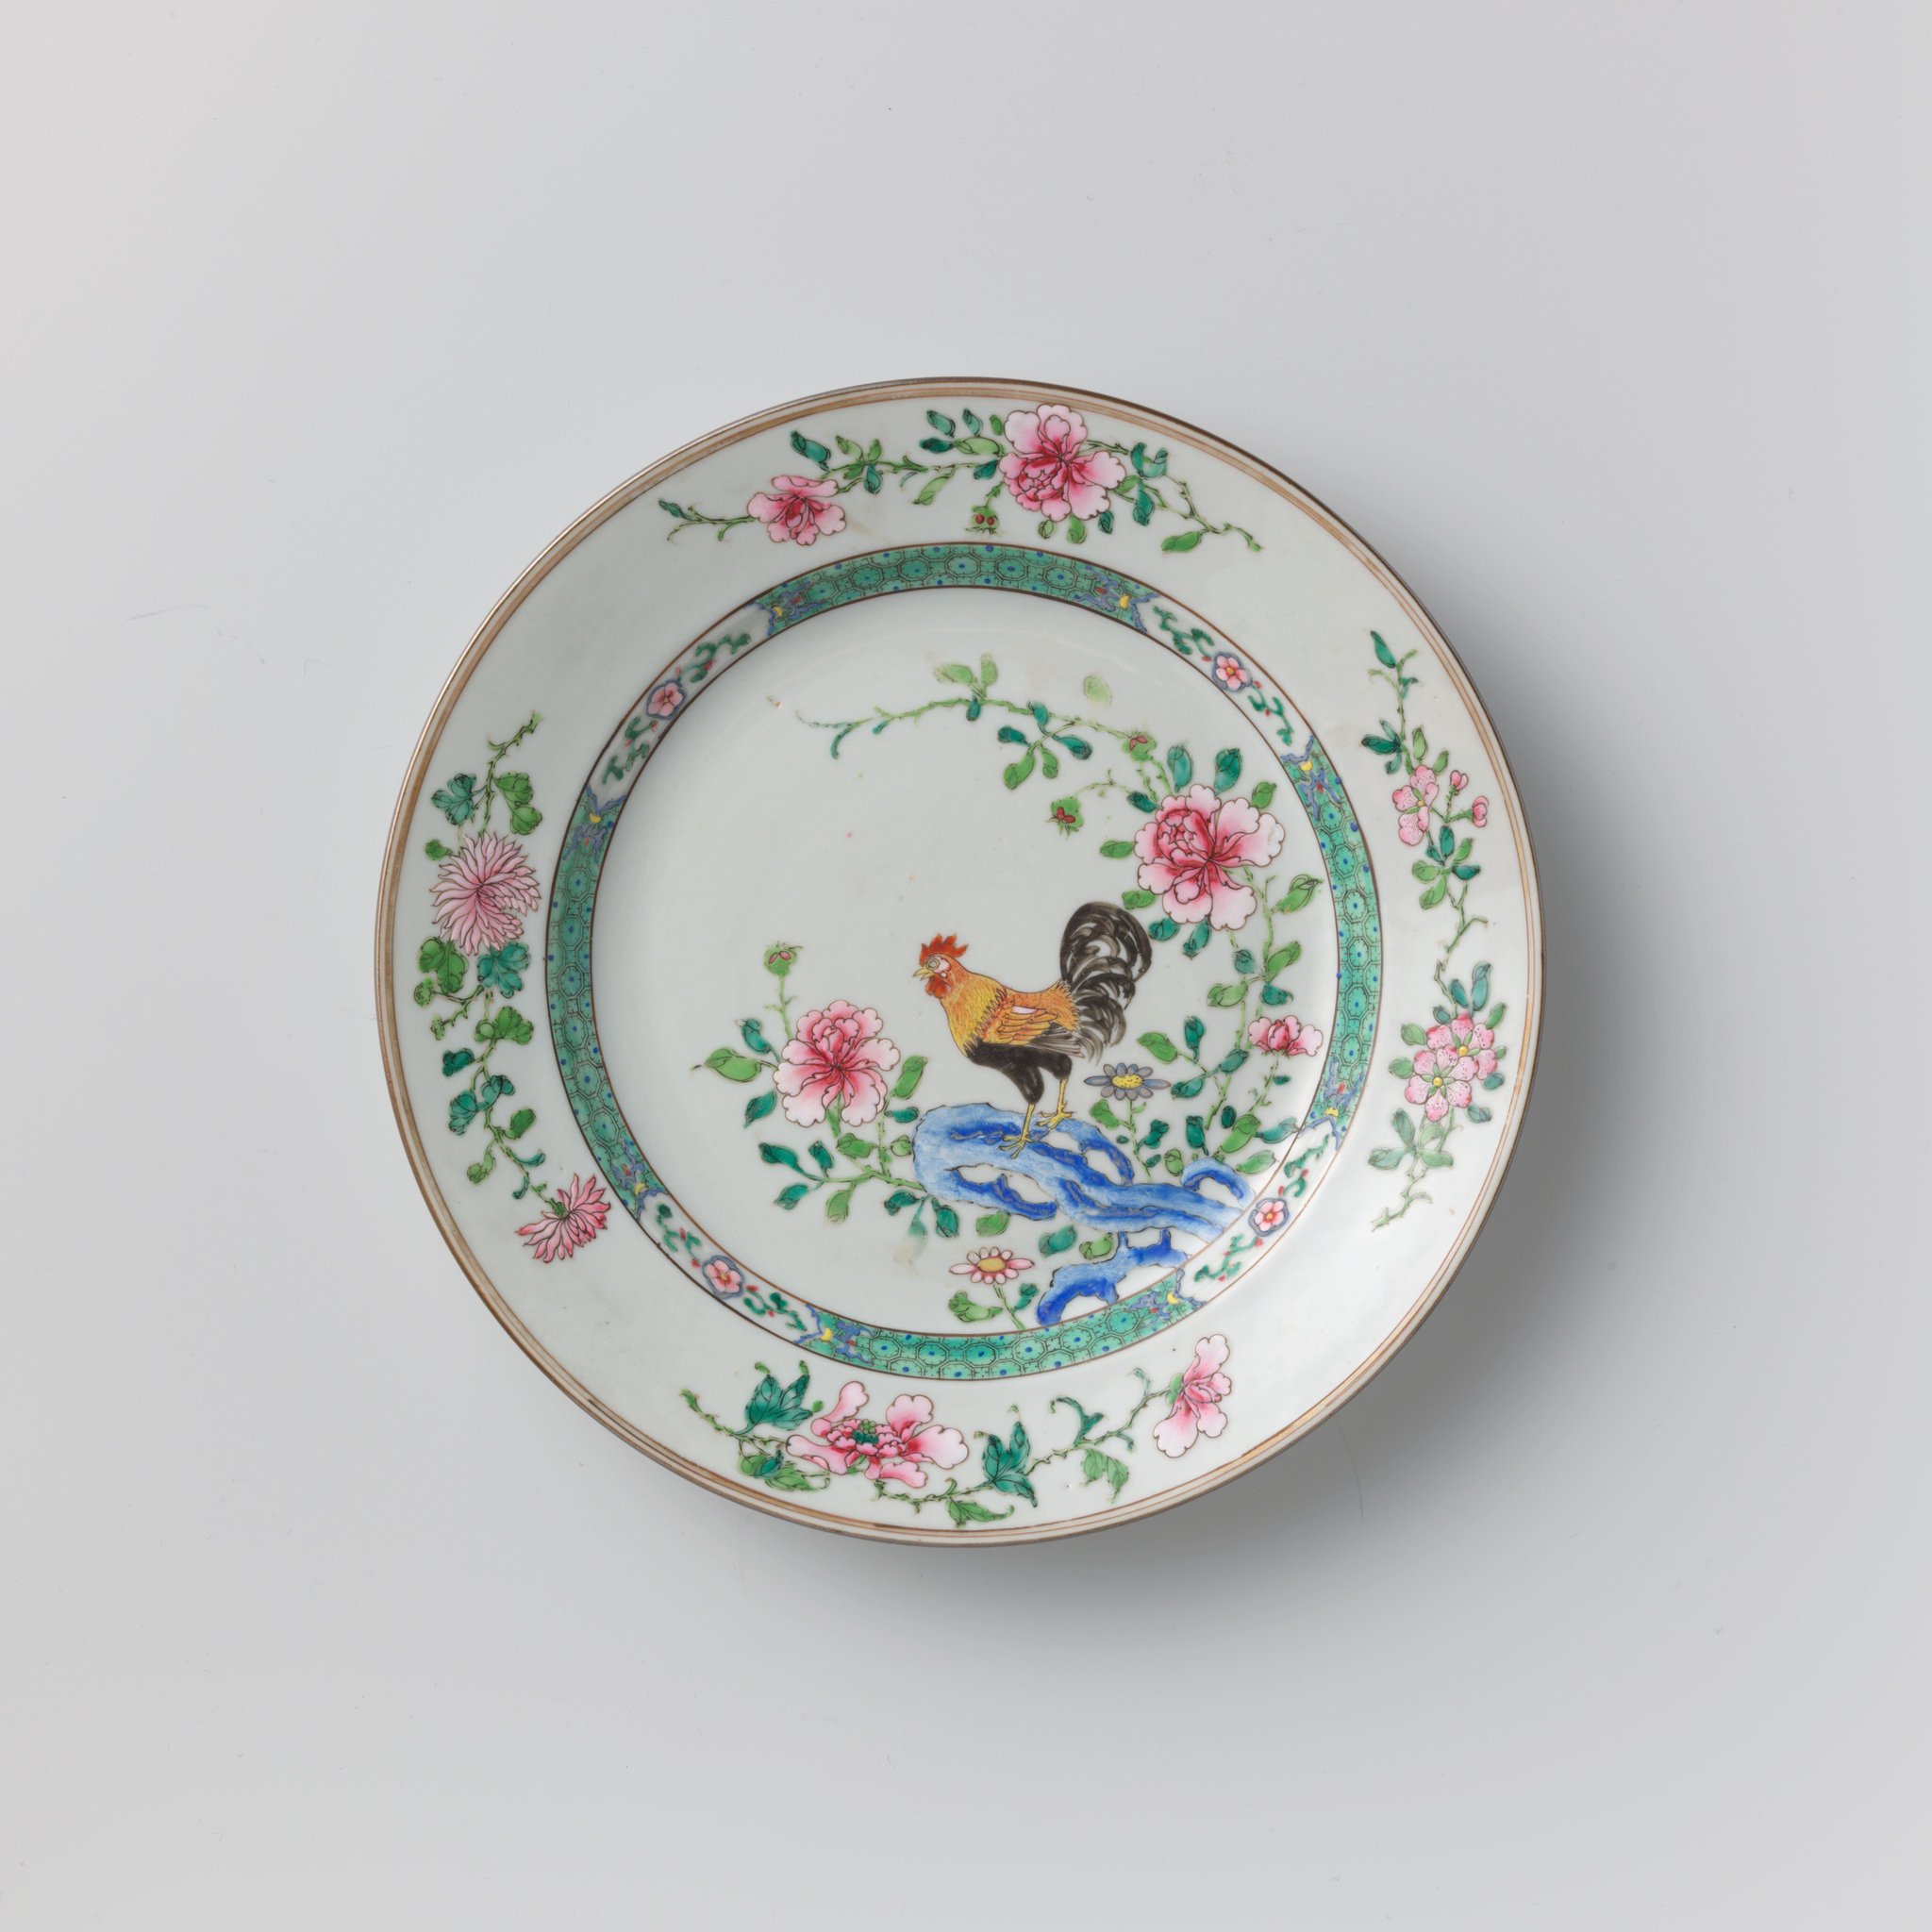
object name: plate dish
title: Plate with a cock on a rock near flowering plants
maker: Anonymous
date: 1725-1749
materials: glaze, paint, porcelain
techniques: firing, turning, vitrification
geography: china